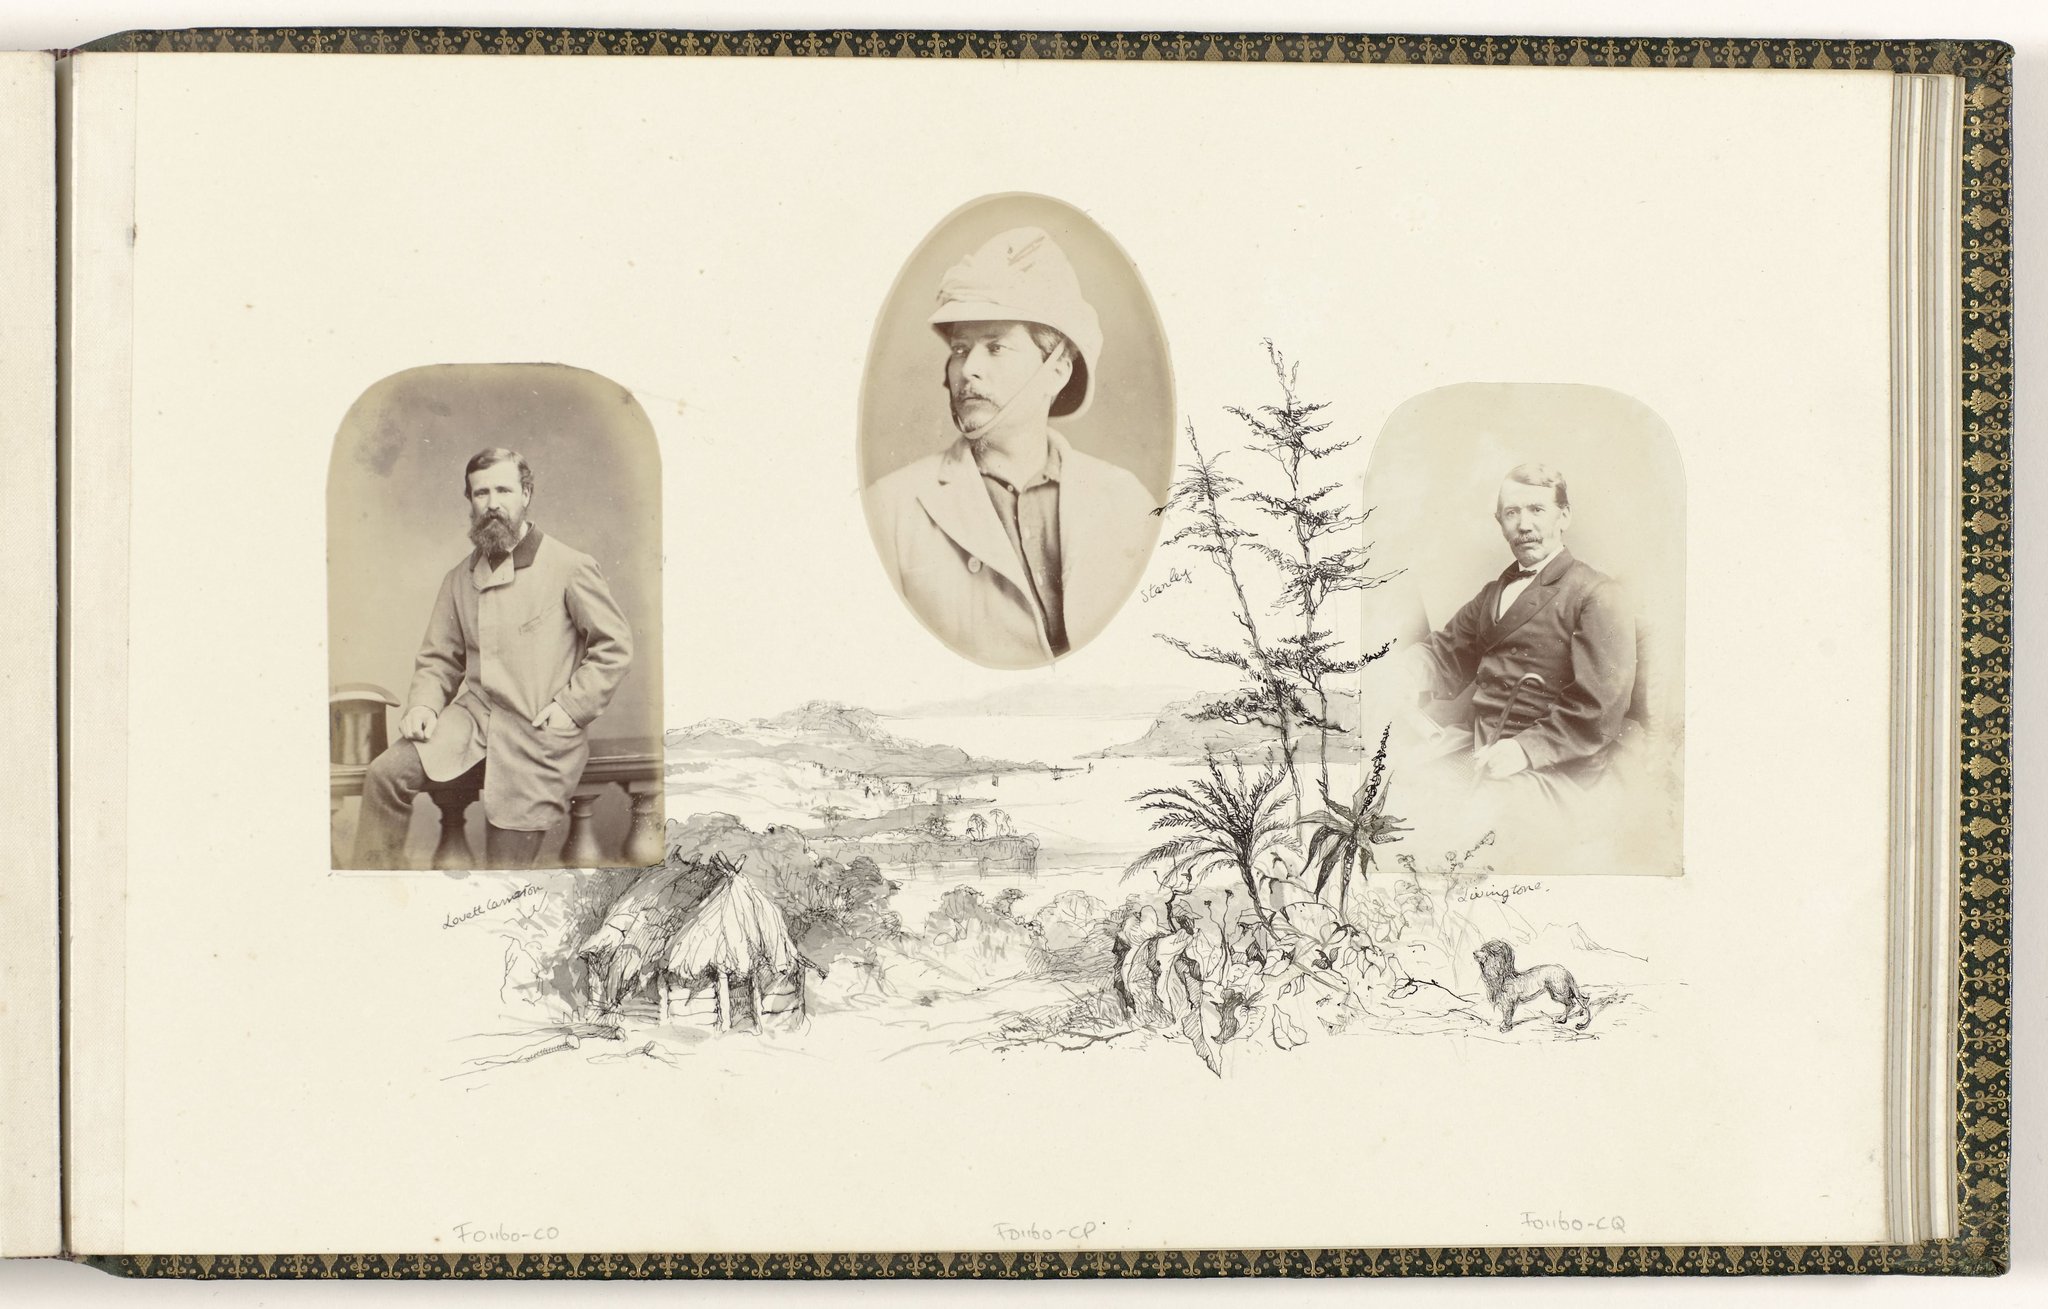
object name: photograph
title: Portret van de ontdekkingsreiziger Verney Lovett Cameron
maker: Anonymous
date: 1870-1880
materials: paper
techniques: albumen print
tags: historical persons, explorer